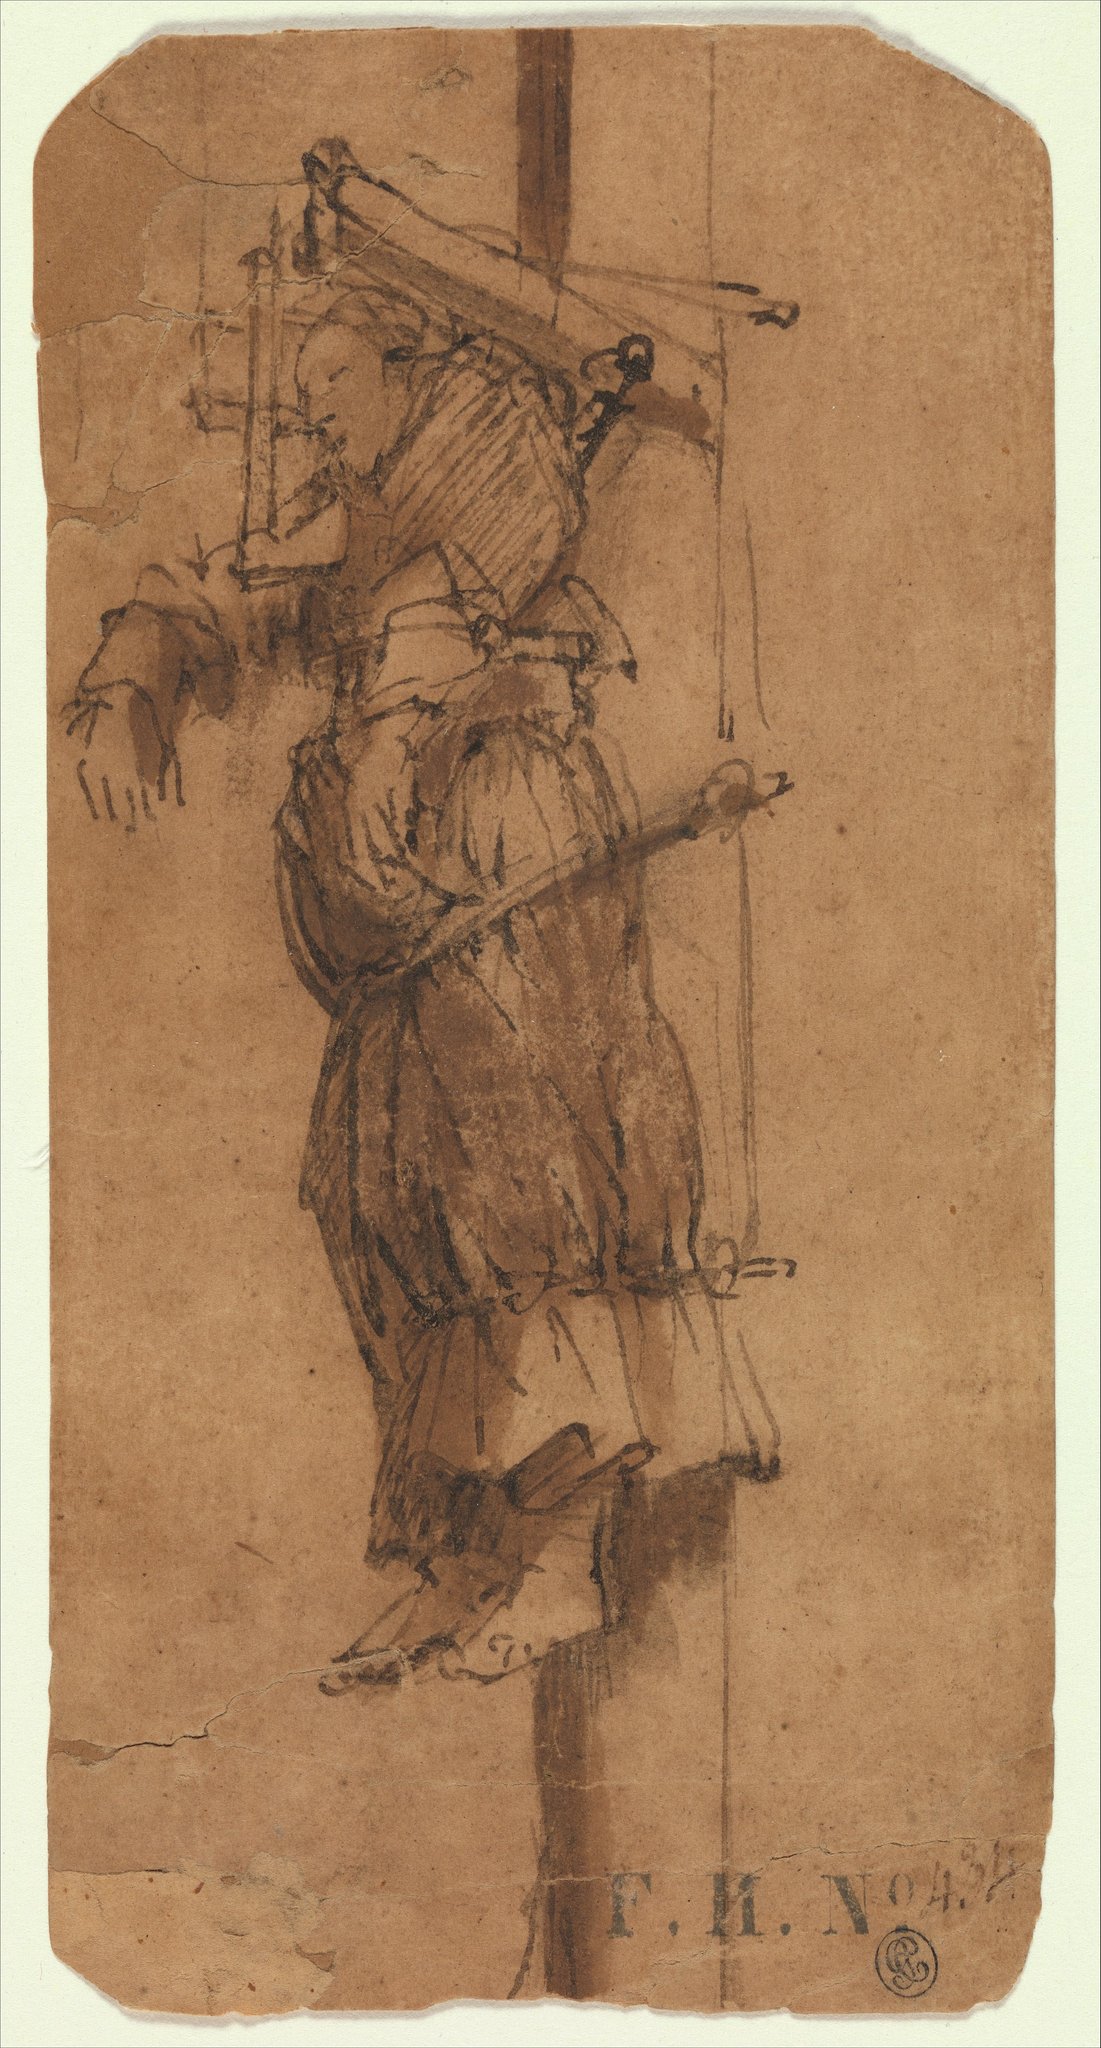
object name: drawing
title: Elsje Christiaens Hanging on a Gibbet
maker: rembrandt van rijn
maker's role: artist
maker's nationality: dutch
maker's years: 1606-1669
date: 1664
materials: ink, paper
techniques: brush, pen, wash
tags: women,execution